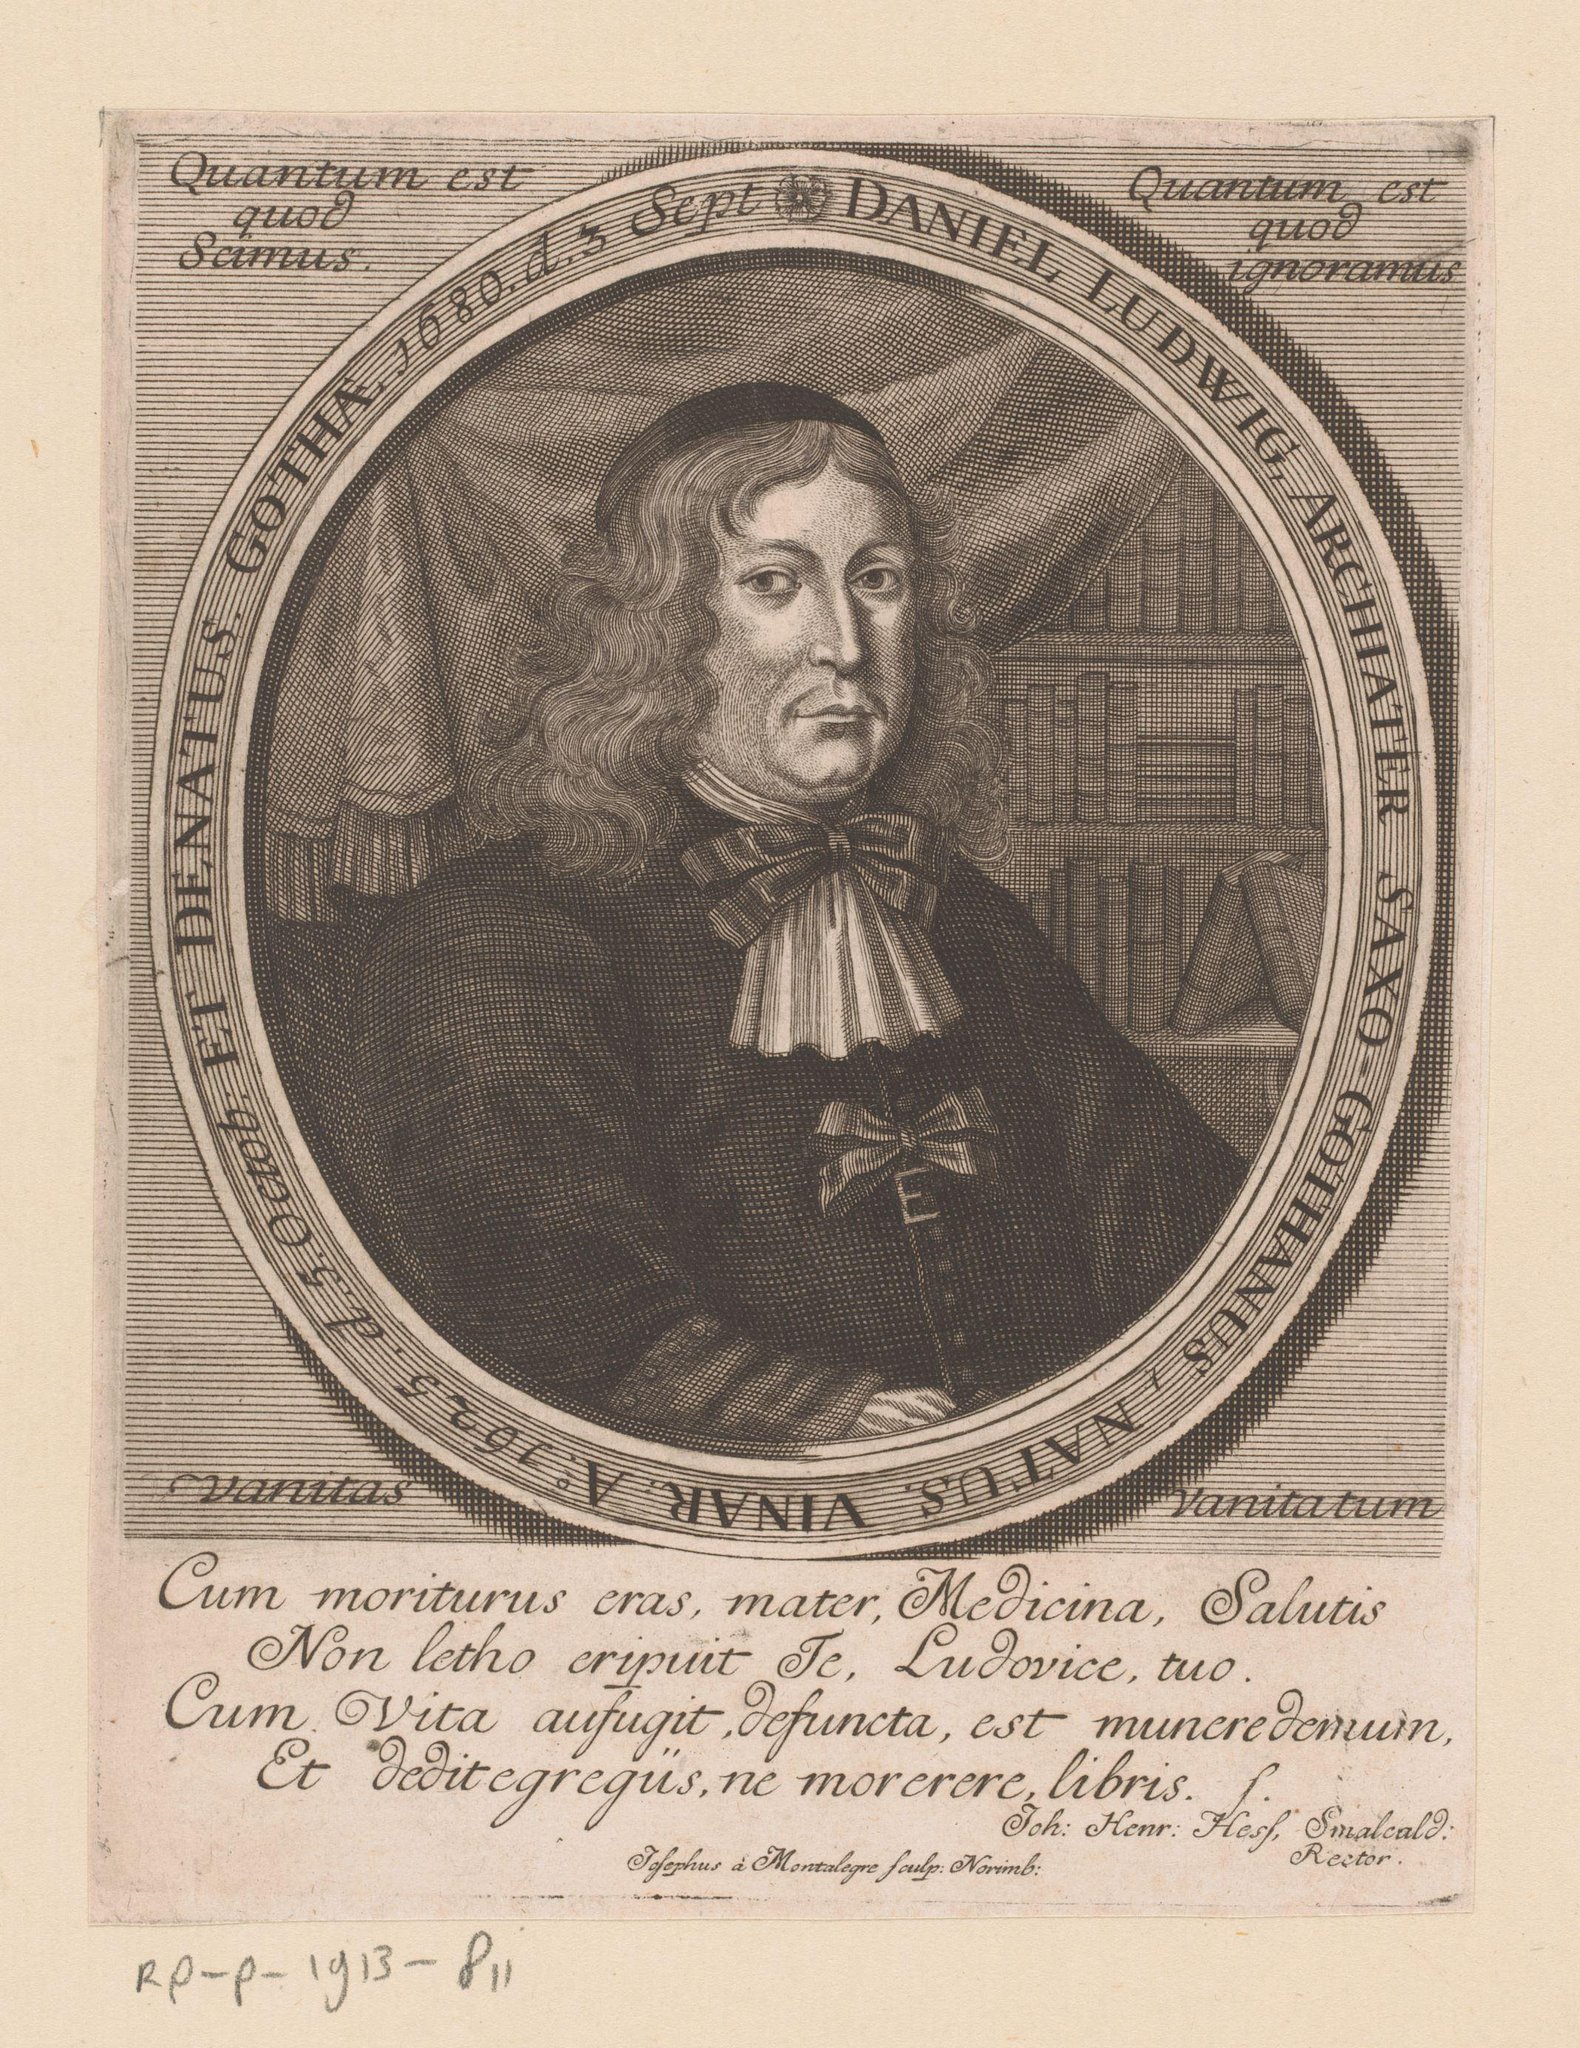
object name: print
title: Portret van Daniel Ludwig Archiater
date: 1680-1799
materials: paper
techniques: engraving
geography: nuremberg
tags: bookshelves, historical persons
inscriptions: collector's mark: Lugt 2228